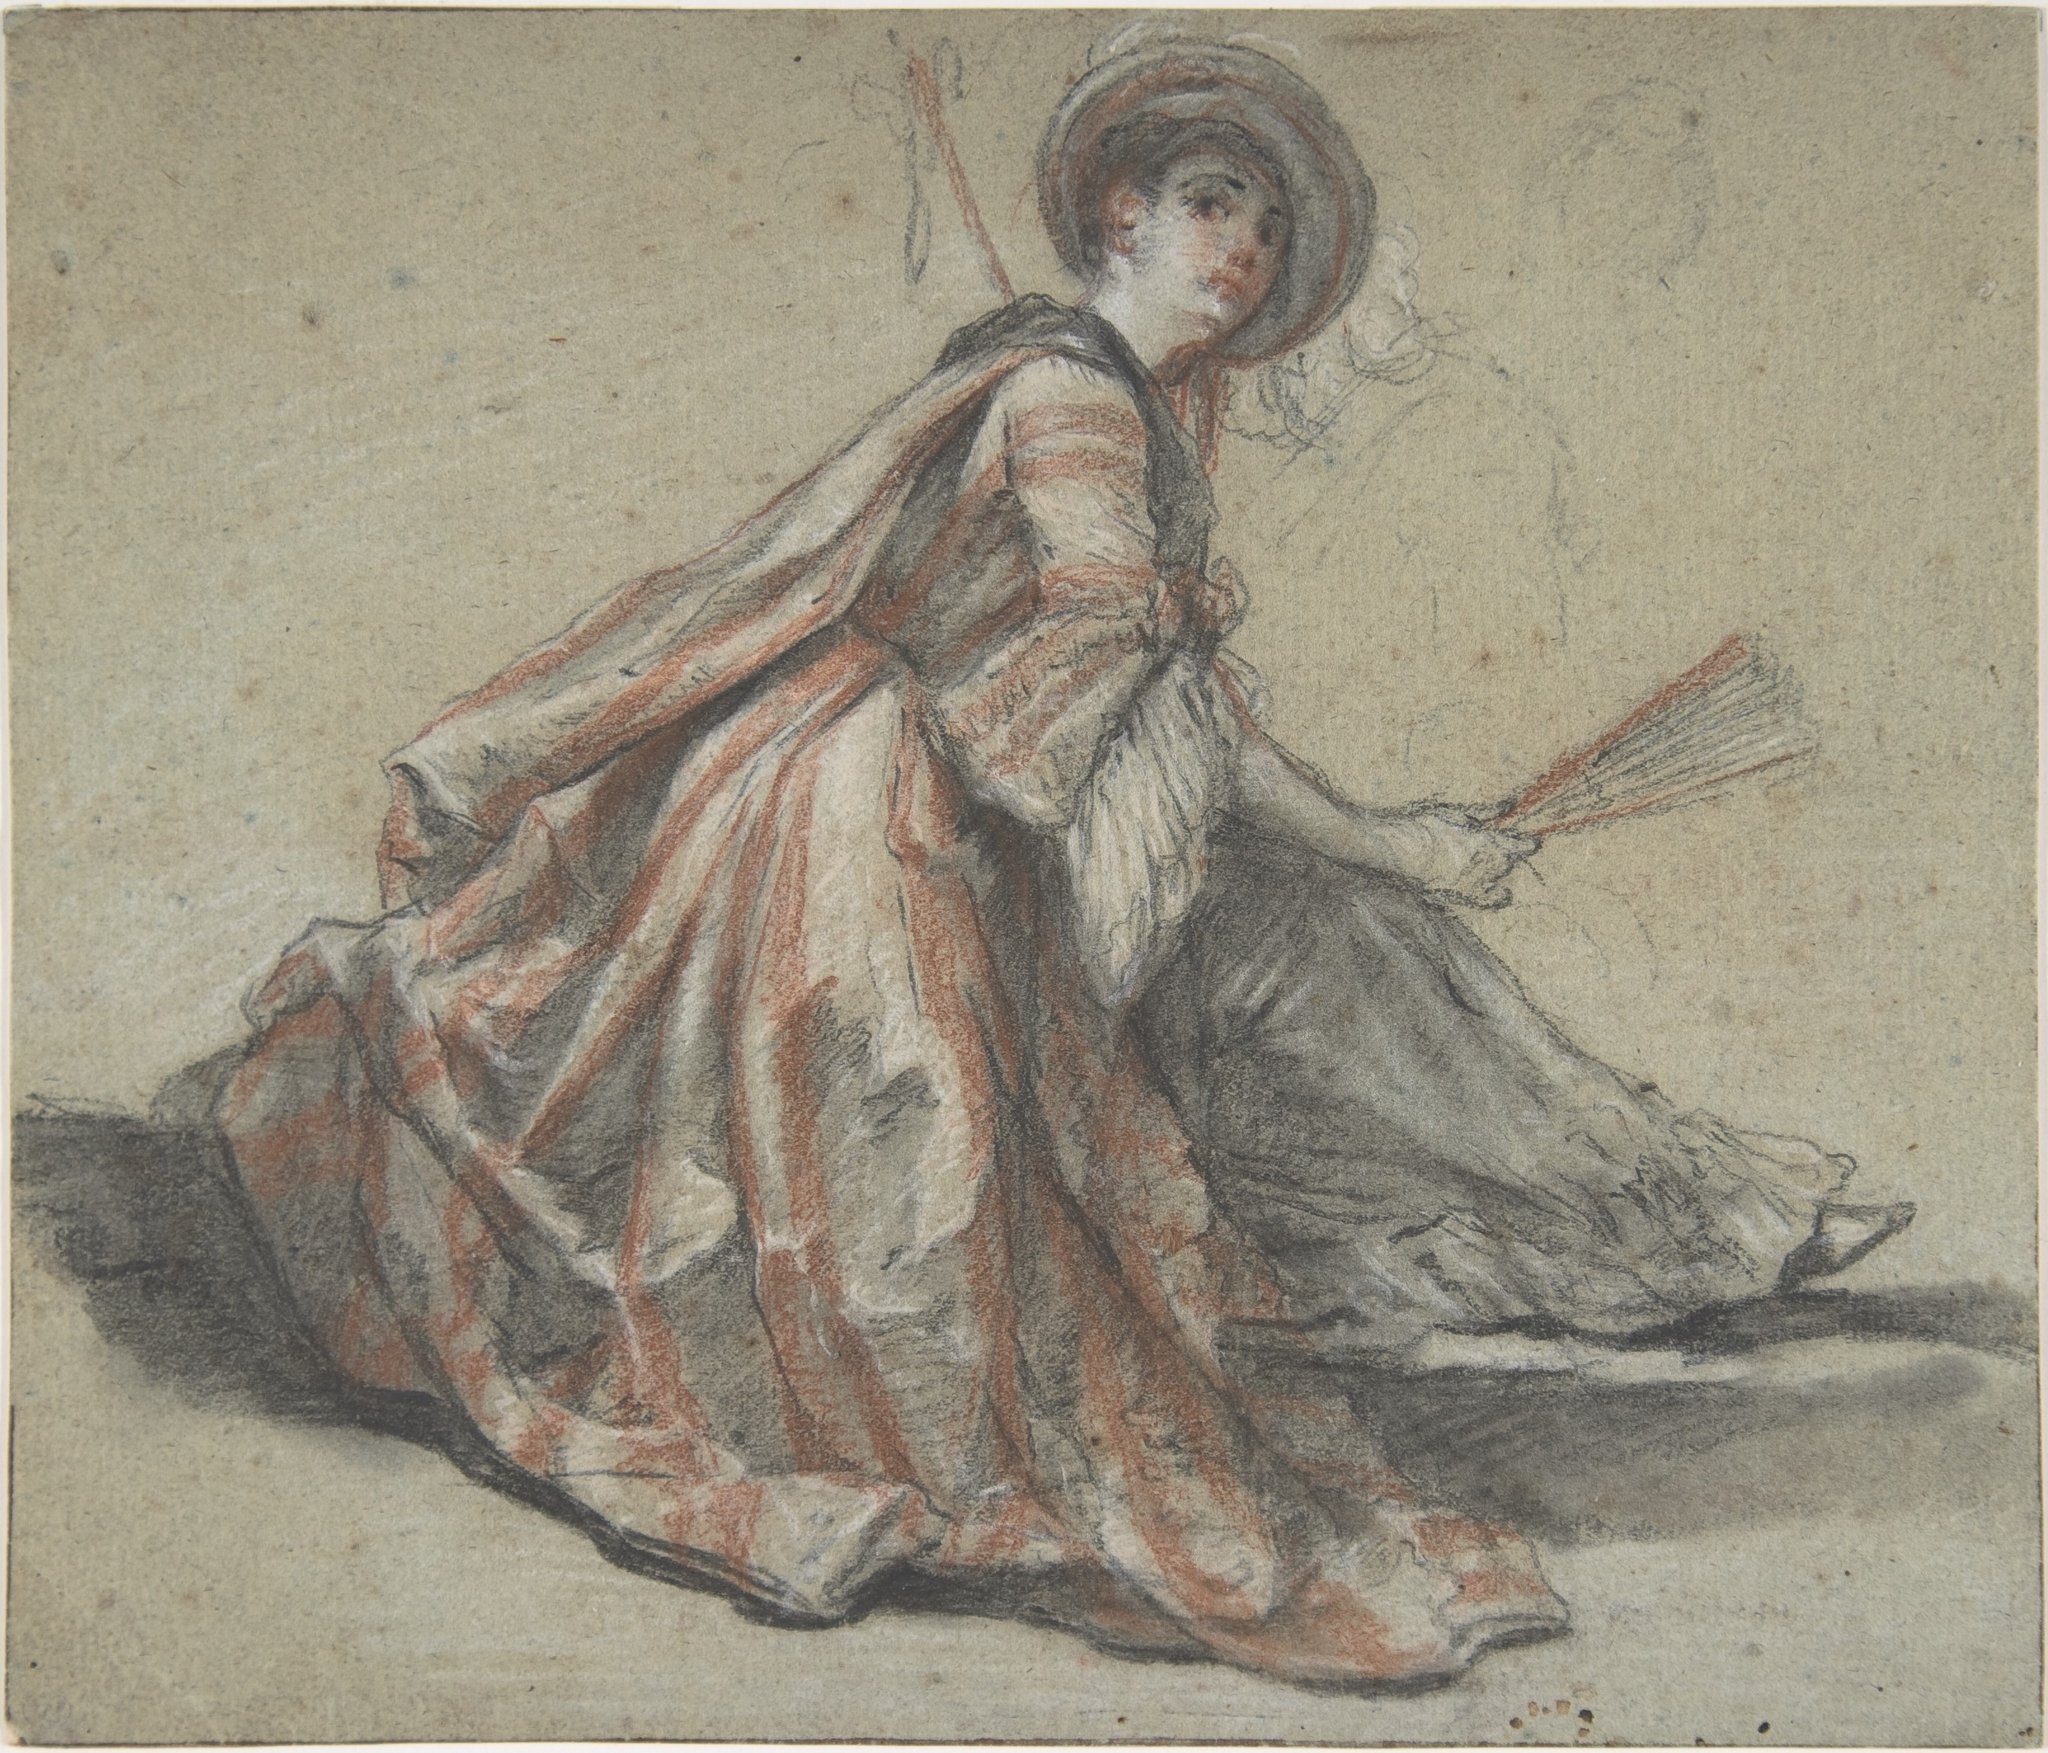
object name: drawing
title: A Lady Holding a Fan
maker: michel barthélémy ollivier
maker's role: artist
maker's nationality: french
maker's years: 1712-1784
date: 1701-1800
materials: chalk, gouache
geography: france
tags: fans,women